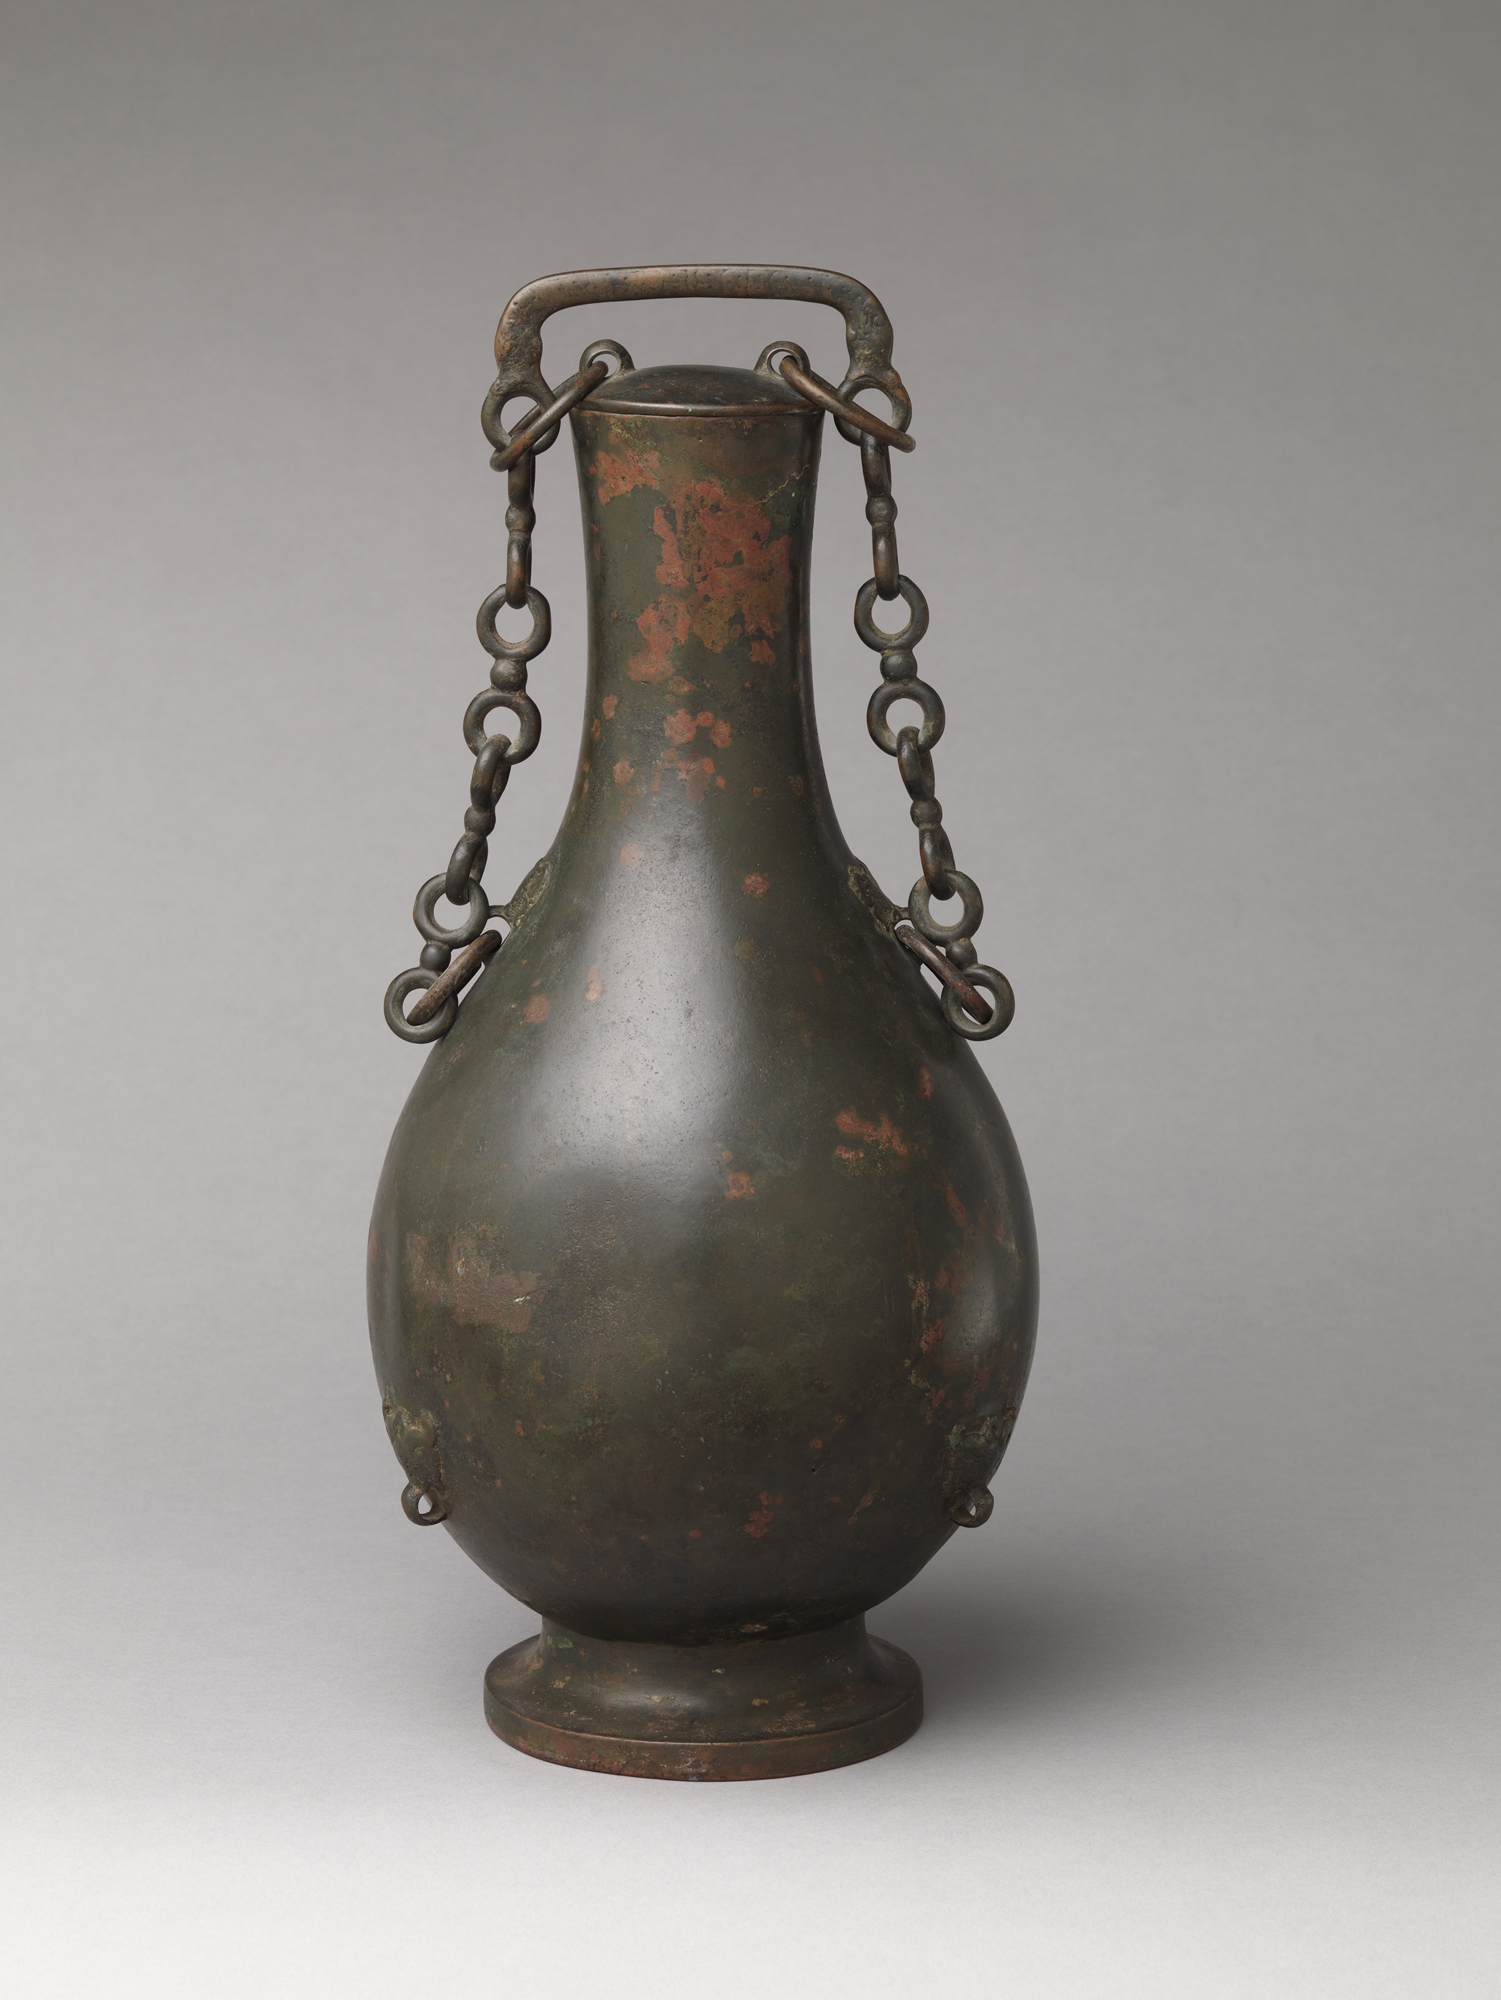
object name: jar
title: Jar (Hu)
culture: chinese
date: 206 BCE-220 CE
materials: bronze